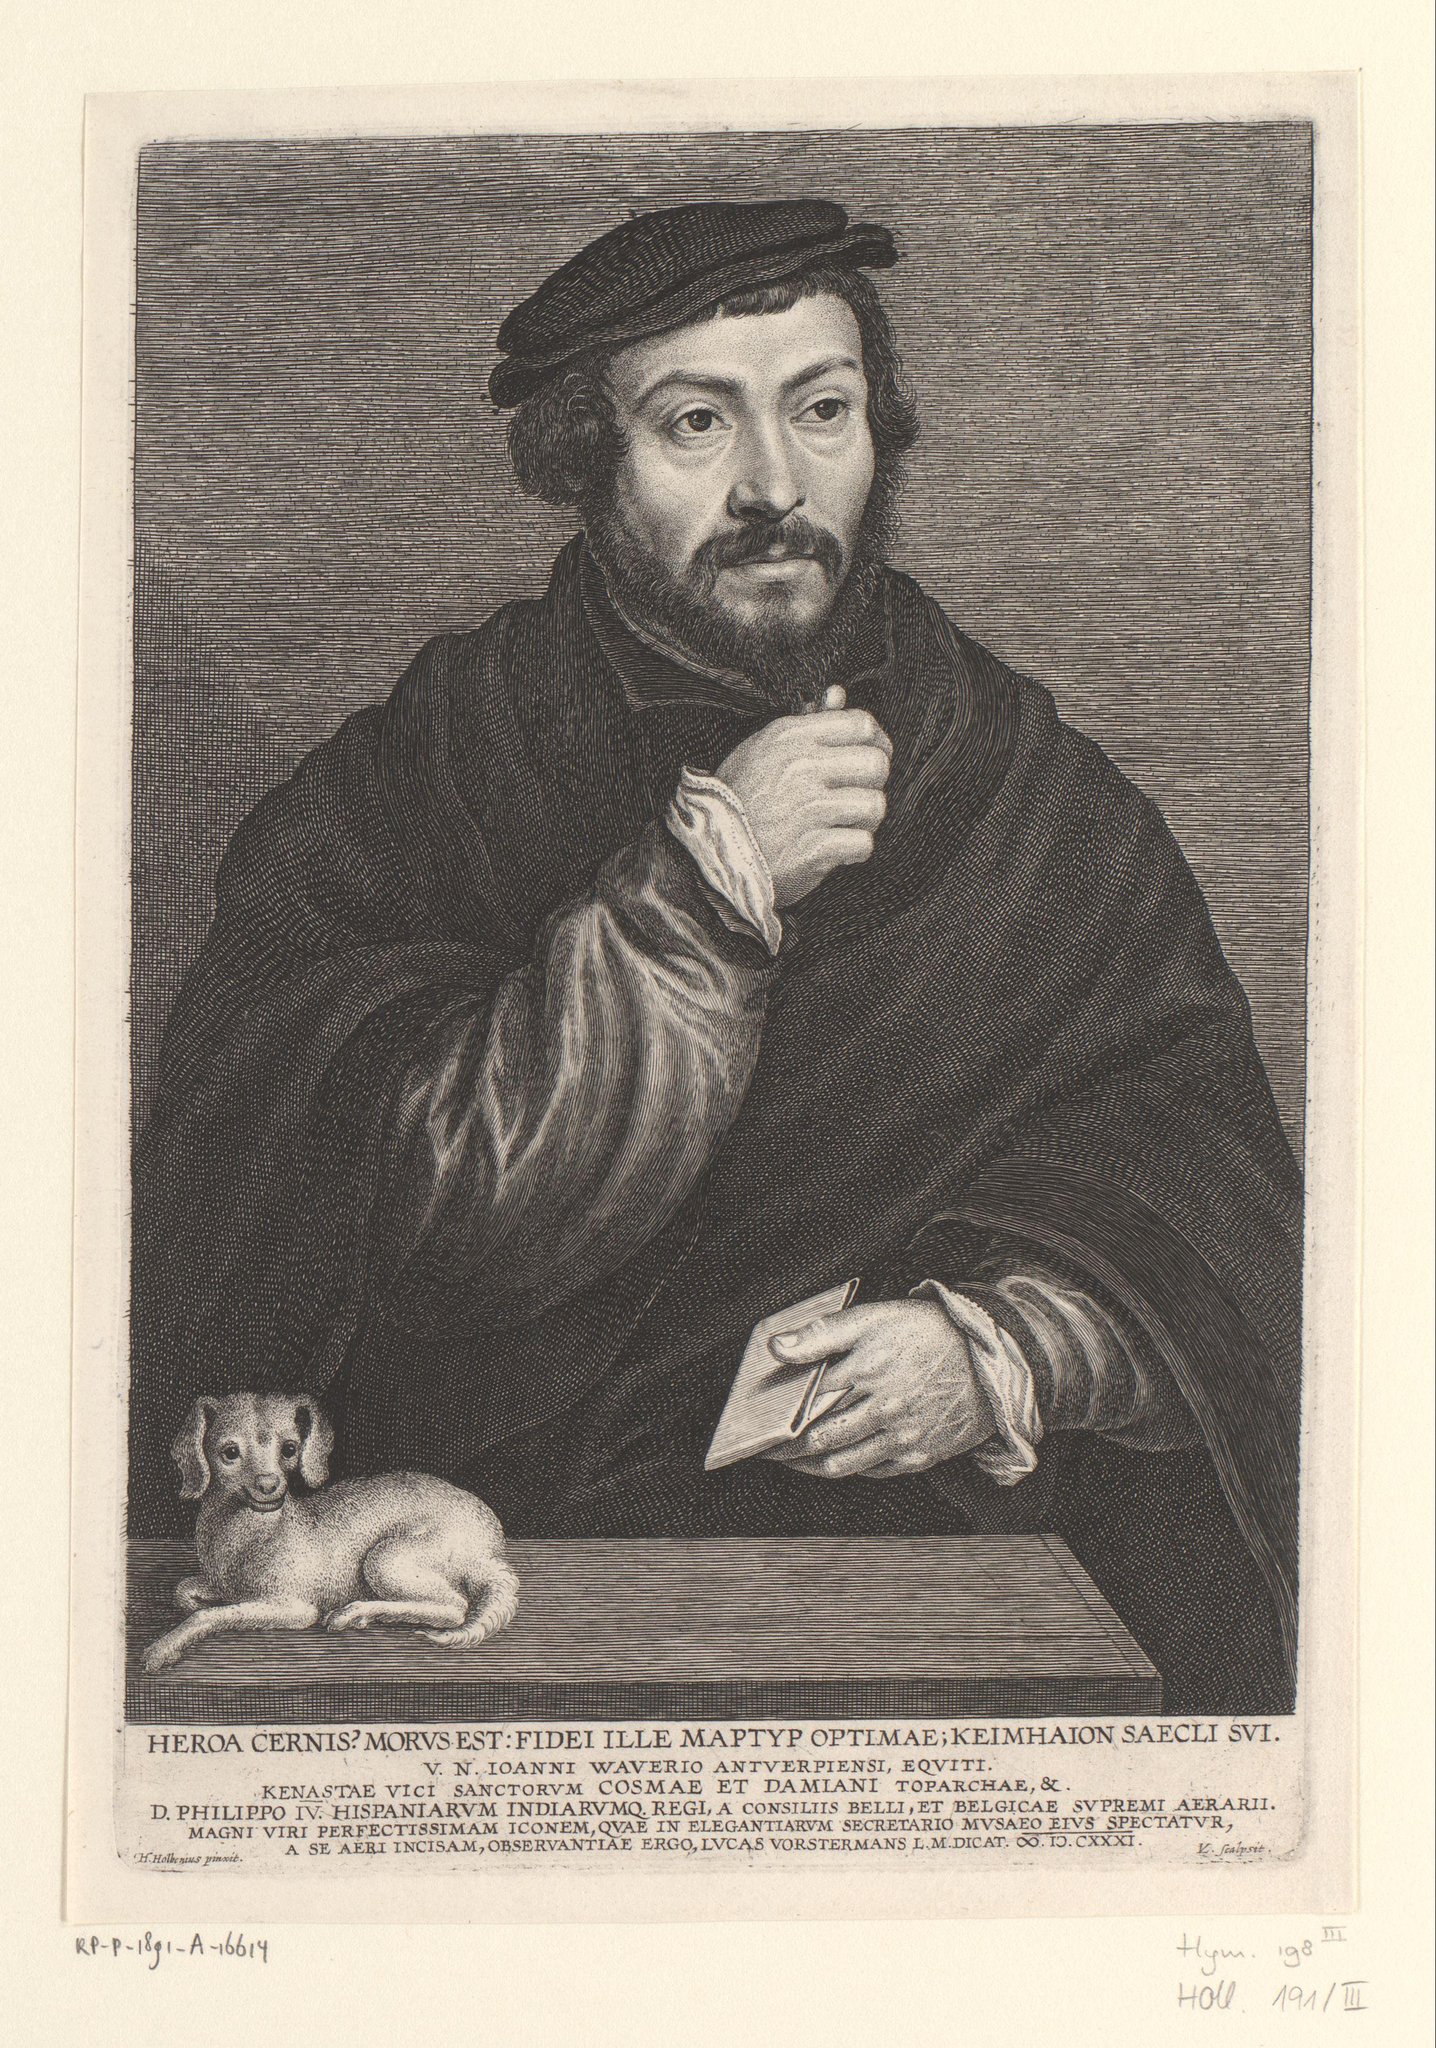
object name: print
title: Portret van sir Thomas More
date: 1631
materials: paper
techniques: engraving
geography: antwerp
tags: london, letter, envelope, dog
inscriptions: collector's mark: Lugt 2228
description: Portret van de Engelse diplomaat en filosoof sir Thomas More.